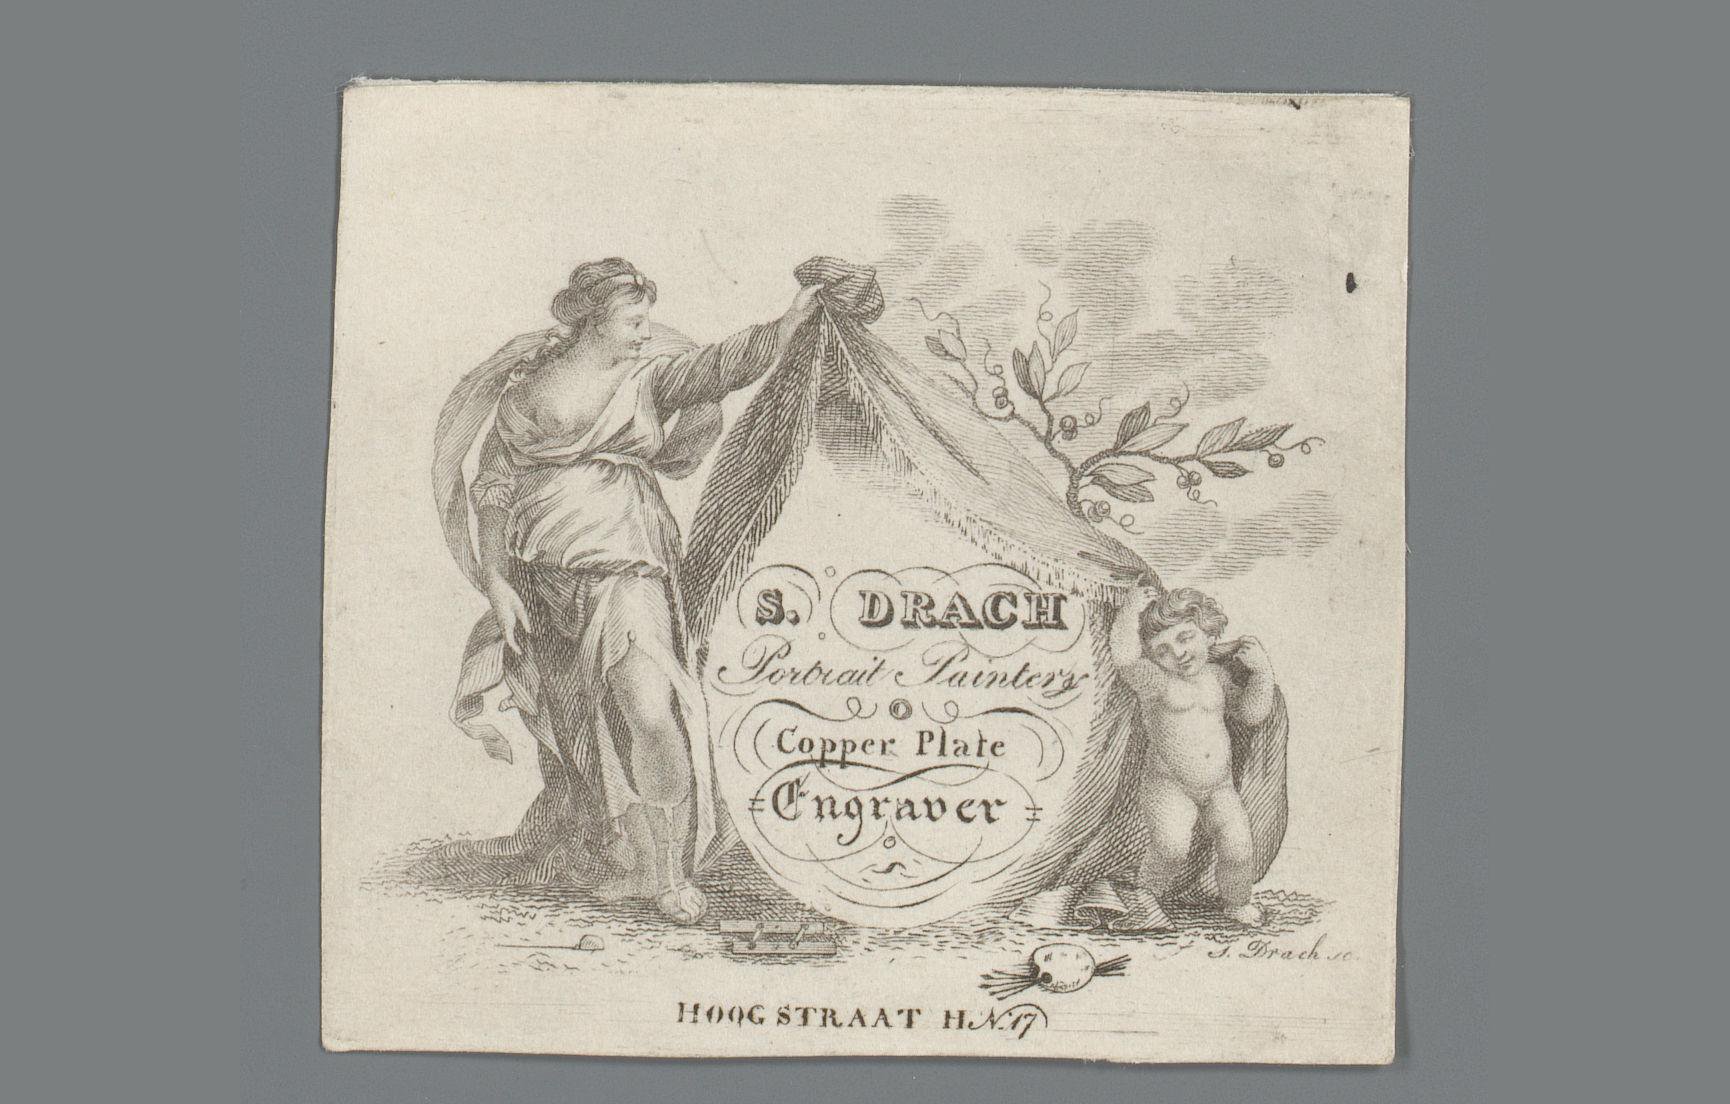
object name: business card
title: Adreskaart van Simon Drach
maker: simon drach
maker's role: painter, print maker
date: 1780-1820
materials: paper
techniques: engraving, etching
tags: simon drach, palette, mother and child(ren), woman and child(ren) (family group)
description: Een vrouw en een kind houden een laken op. Daarachter: 'S. Drach Portrait Painters Copper Plate Engraver. Hoogstraat H. no. 17'.